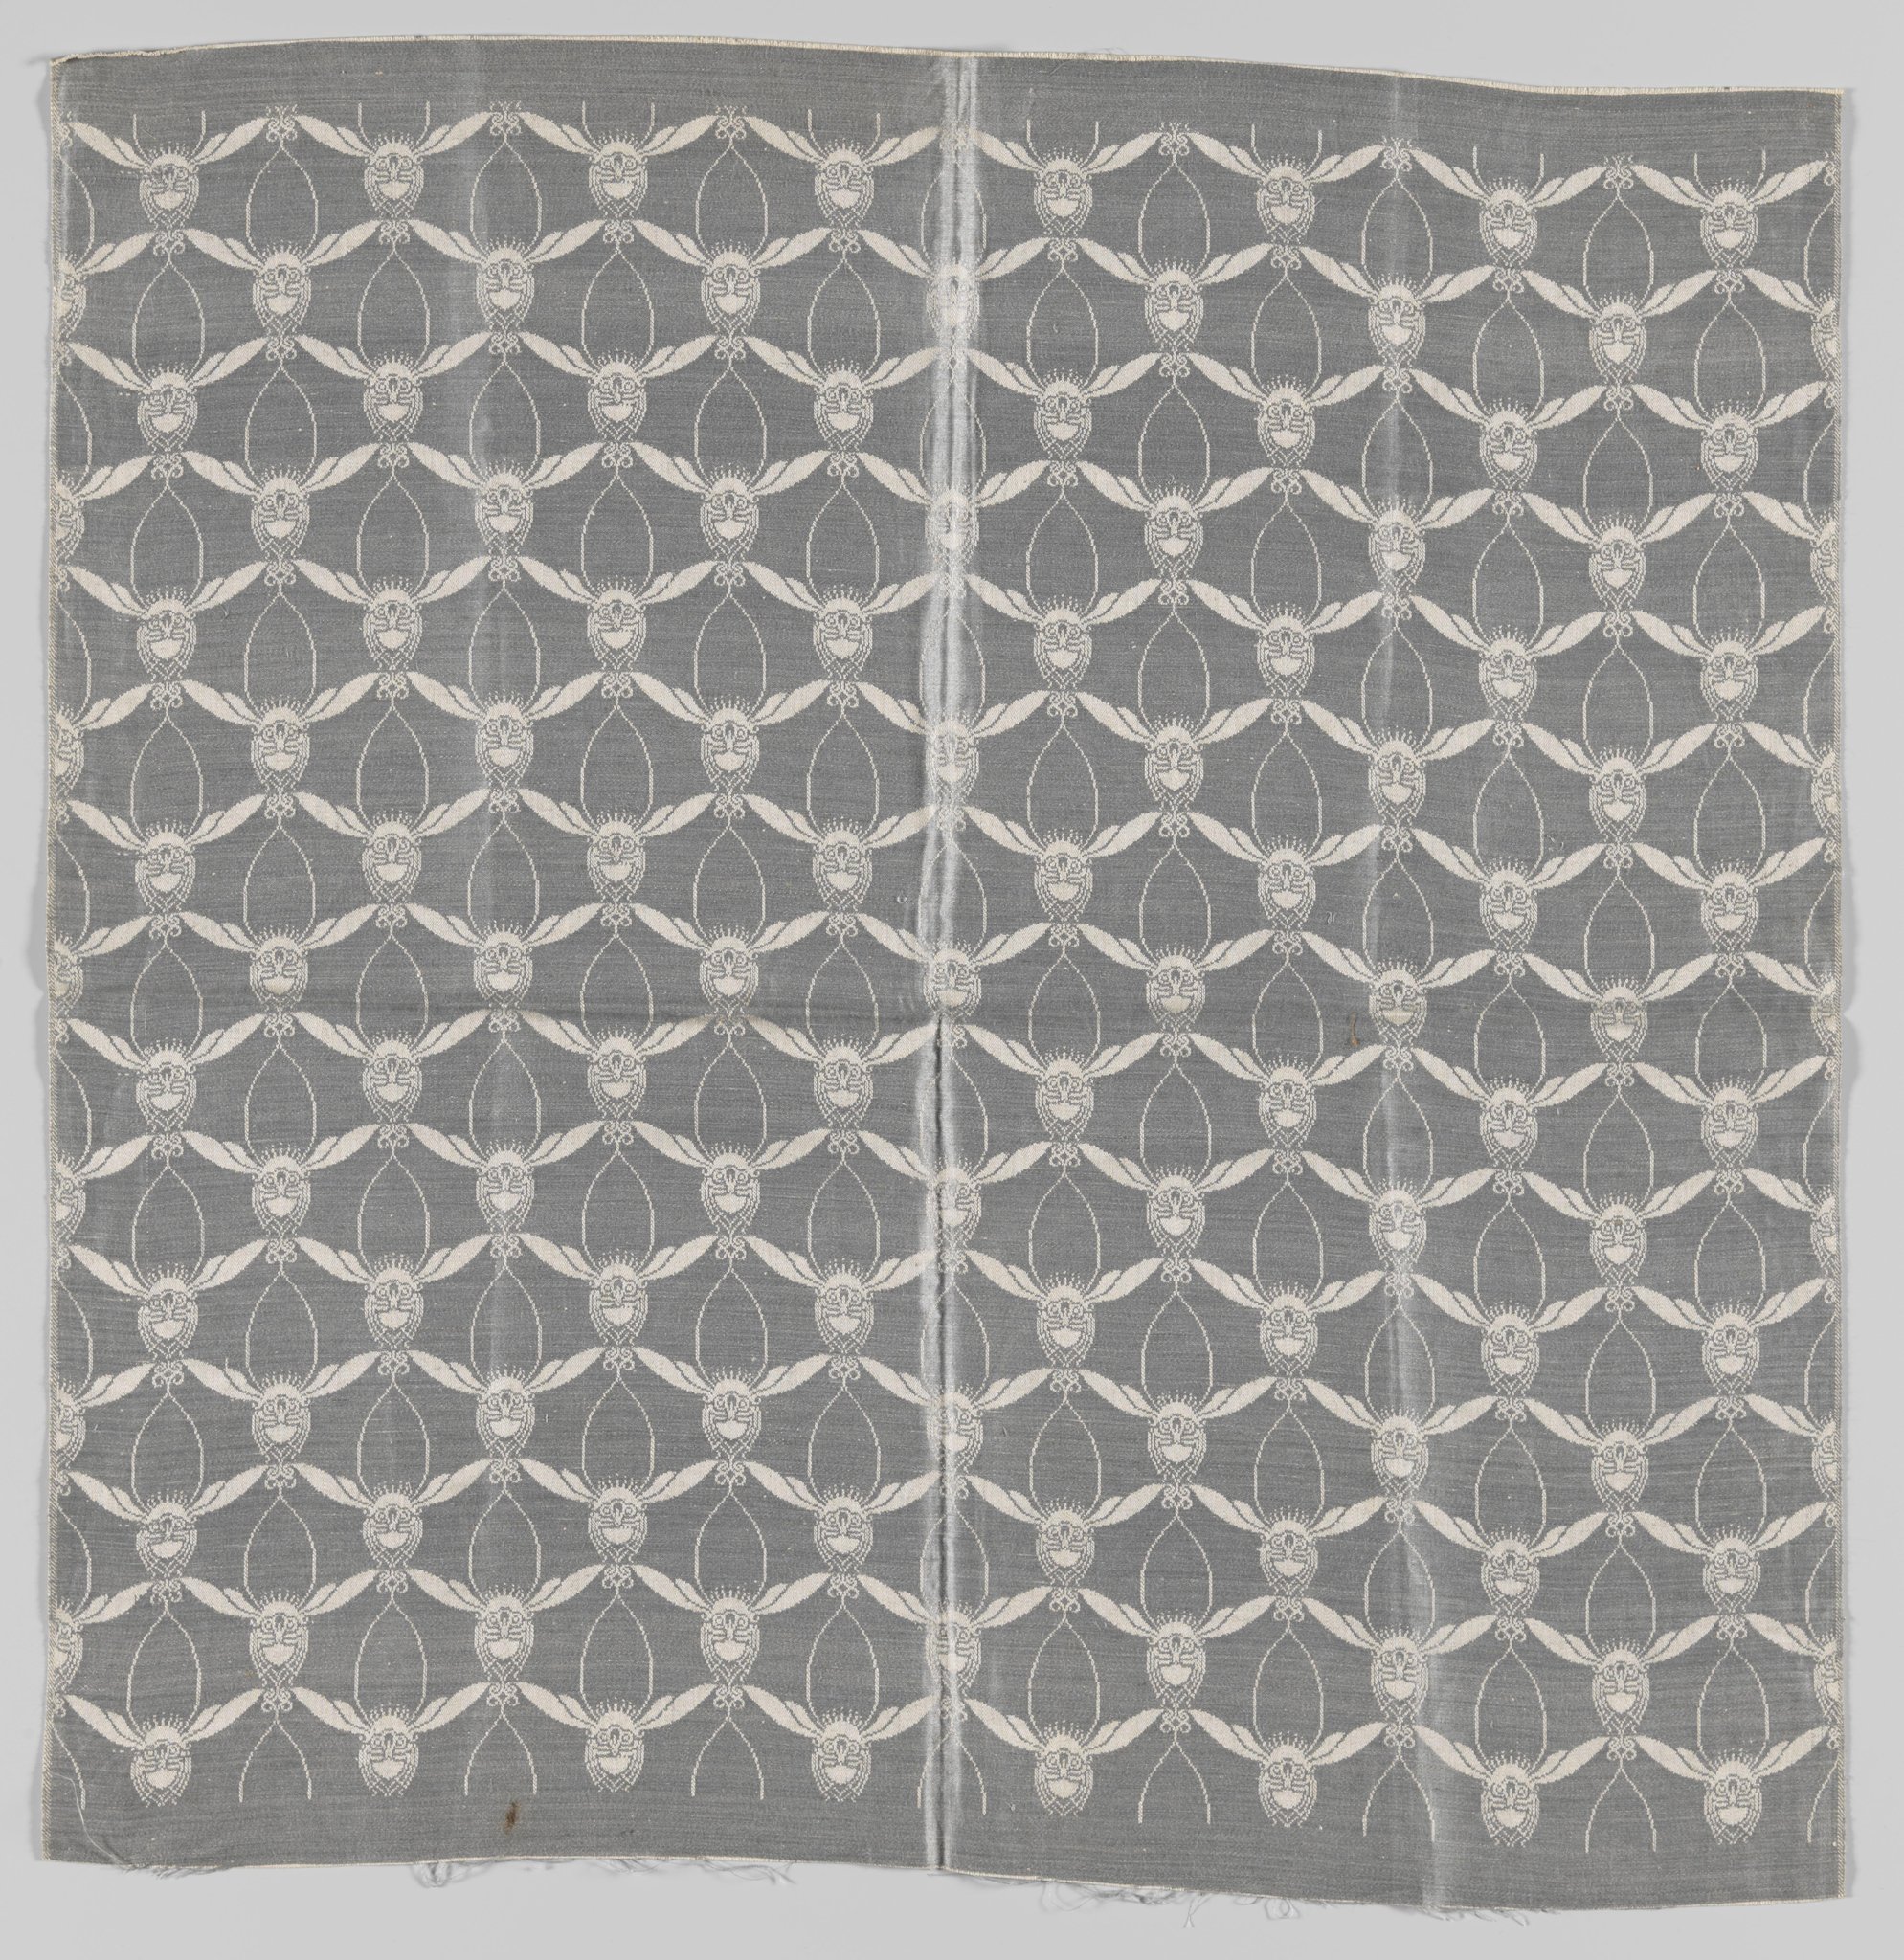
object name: upholstery fabric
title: Staal bespanningsstof van linnendamast met dessin "Wilde Vlucht"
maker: chris lebeau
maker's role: draughtsman, print maker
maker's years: 1878-1945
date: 1911-1915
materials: linen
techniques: damask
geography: eindhoven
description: Staal bespanningsstof van linnendamast met een dessin van bijen (of vogels) in wilde vlucht, in naturel op een grijsblauwe grond.